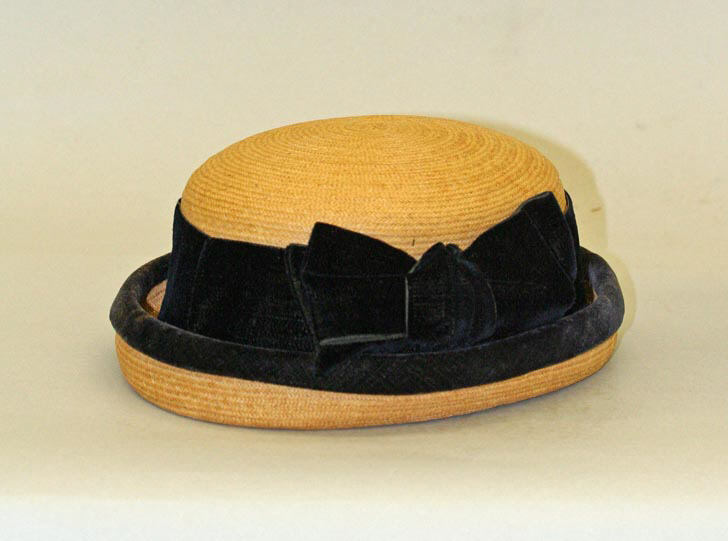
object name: hat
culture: american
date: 1868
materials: fiber